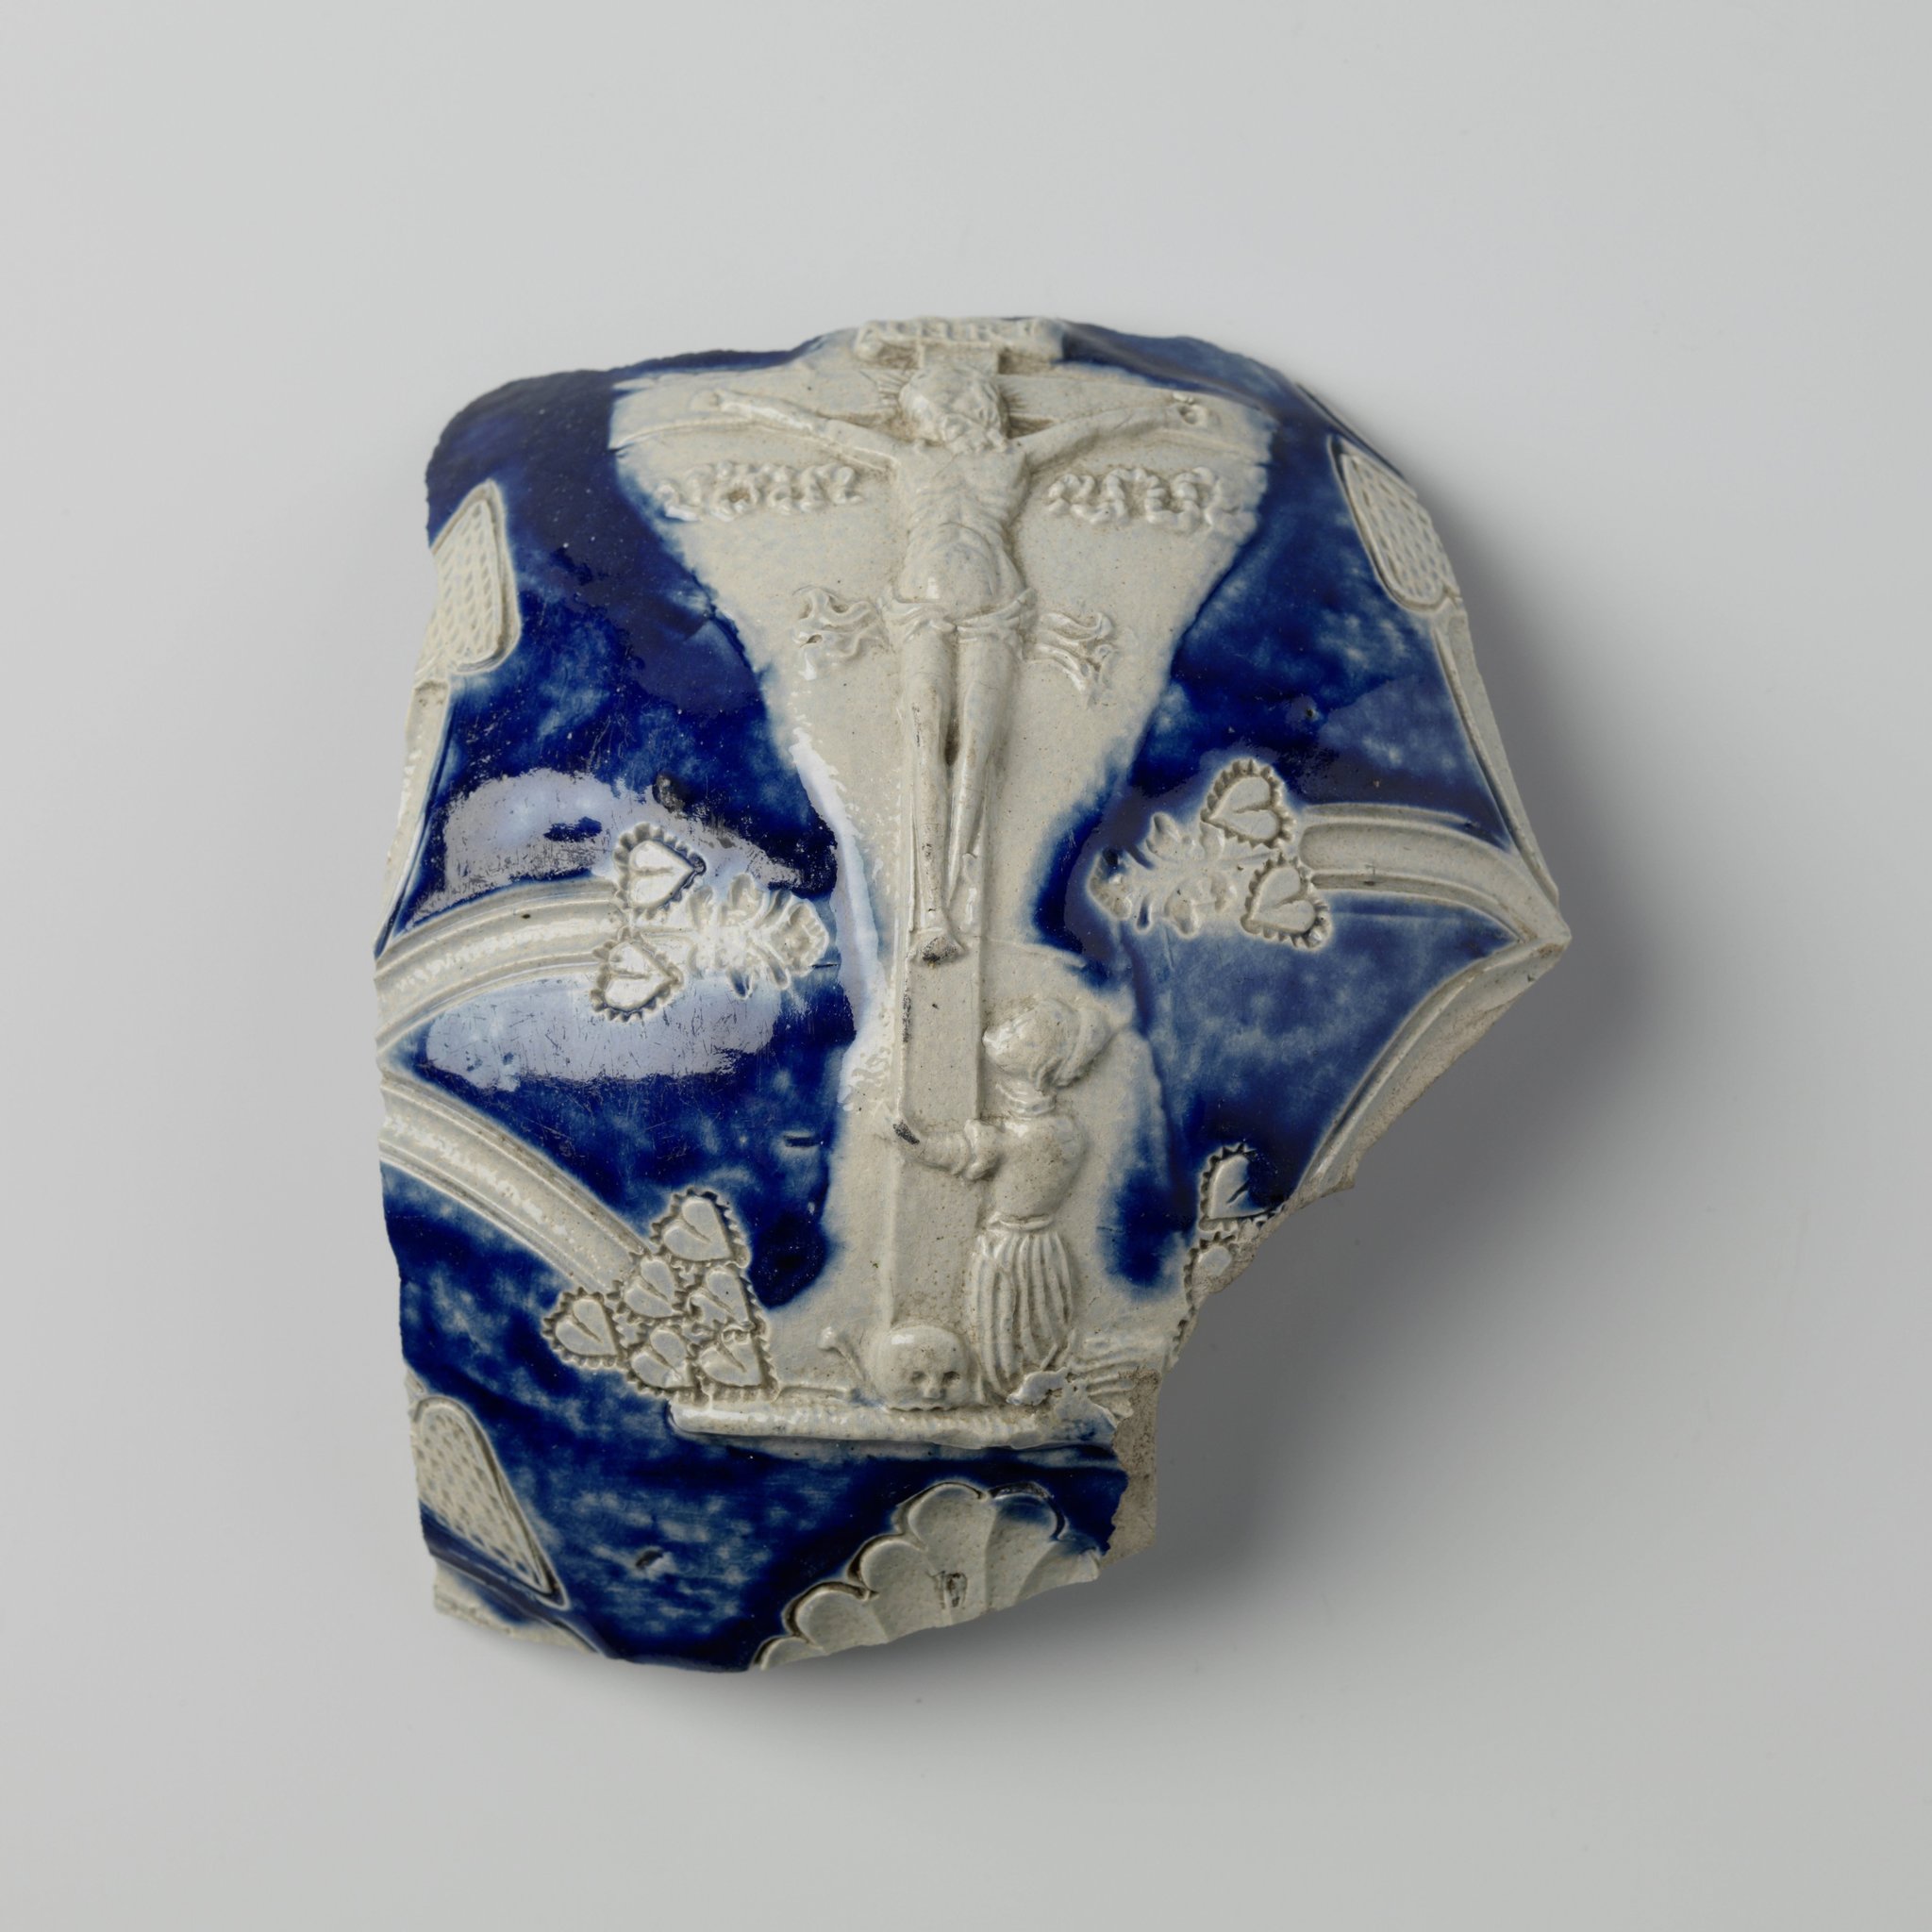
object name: fragment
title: Fragment of a jug with the Crucifixion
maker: Anonymous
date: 1630-1680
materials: cobalt, glaze, stoneware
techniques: printing, firing, forming, relief, turning, vitrification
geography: westerwald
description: Fragment van een kruik van steengoed. Gedeeltelijk bedekt met kobaltblauw. Het fragment toont een gedrukte en opgelegde voorstelling in reliëf van de Kruisiging met Maria Magdalena en de schedel aan de voet van het kruis. De scène is omringd door ingegrifte en gestempelde bloemranken. Westerwald.